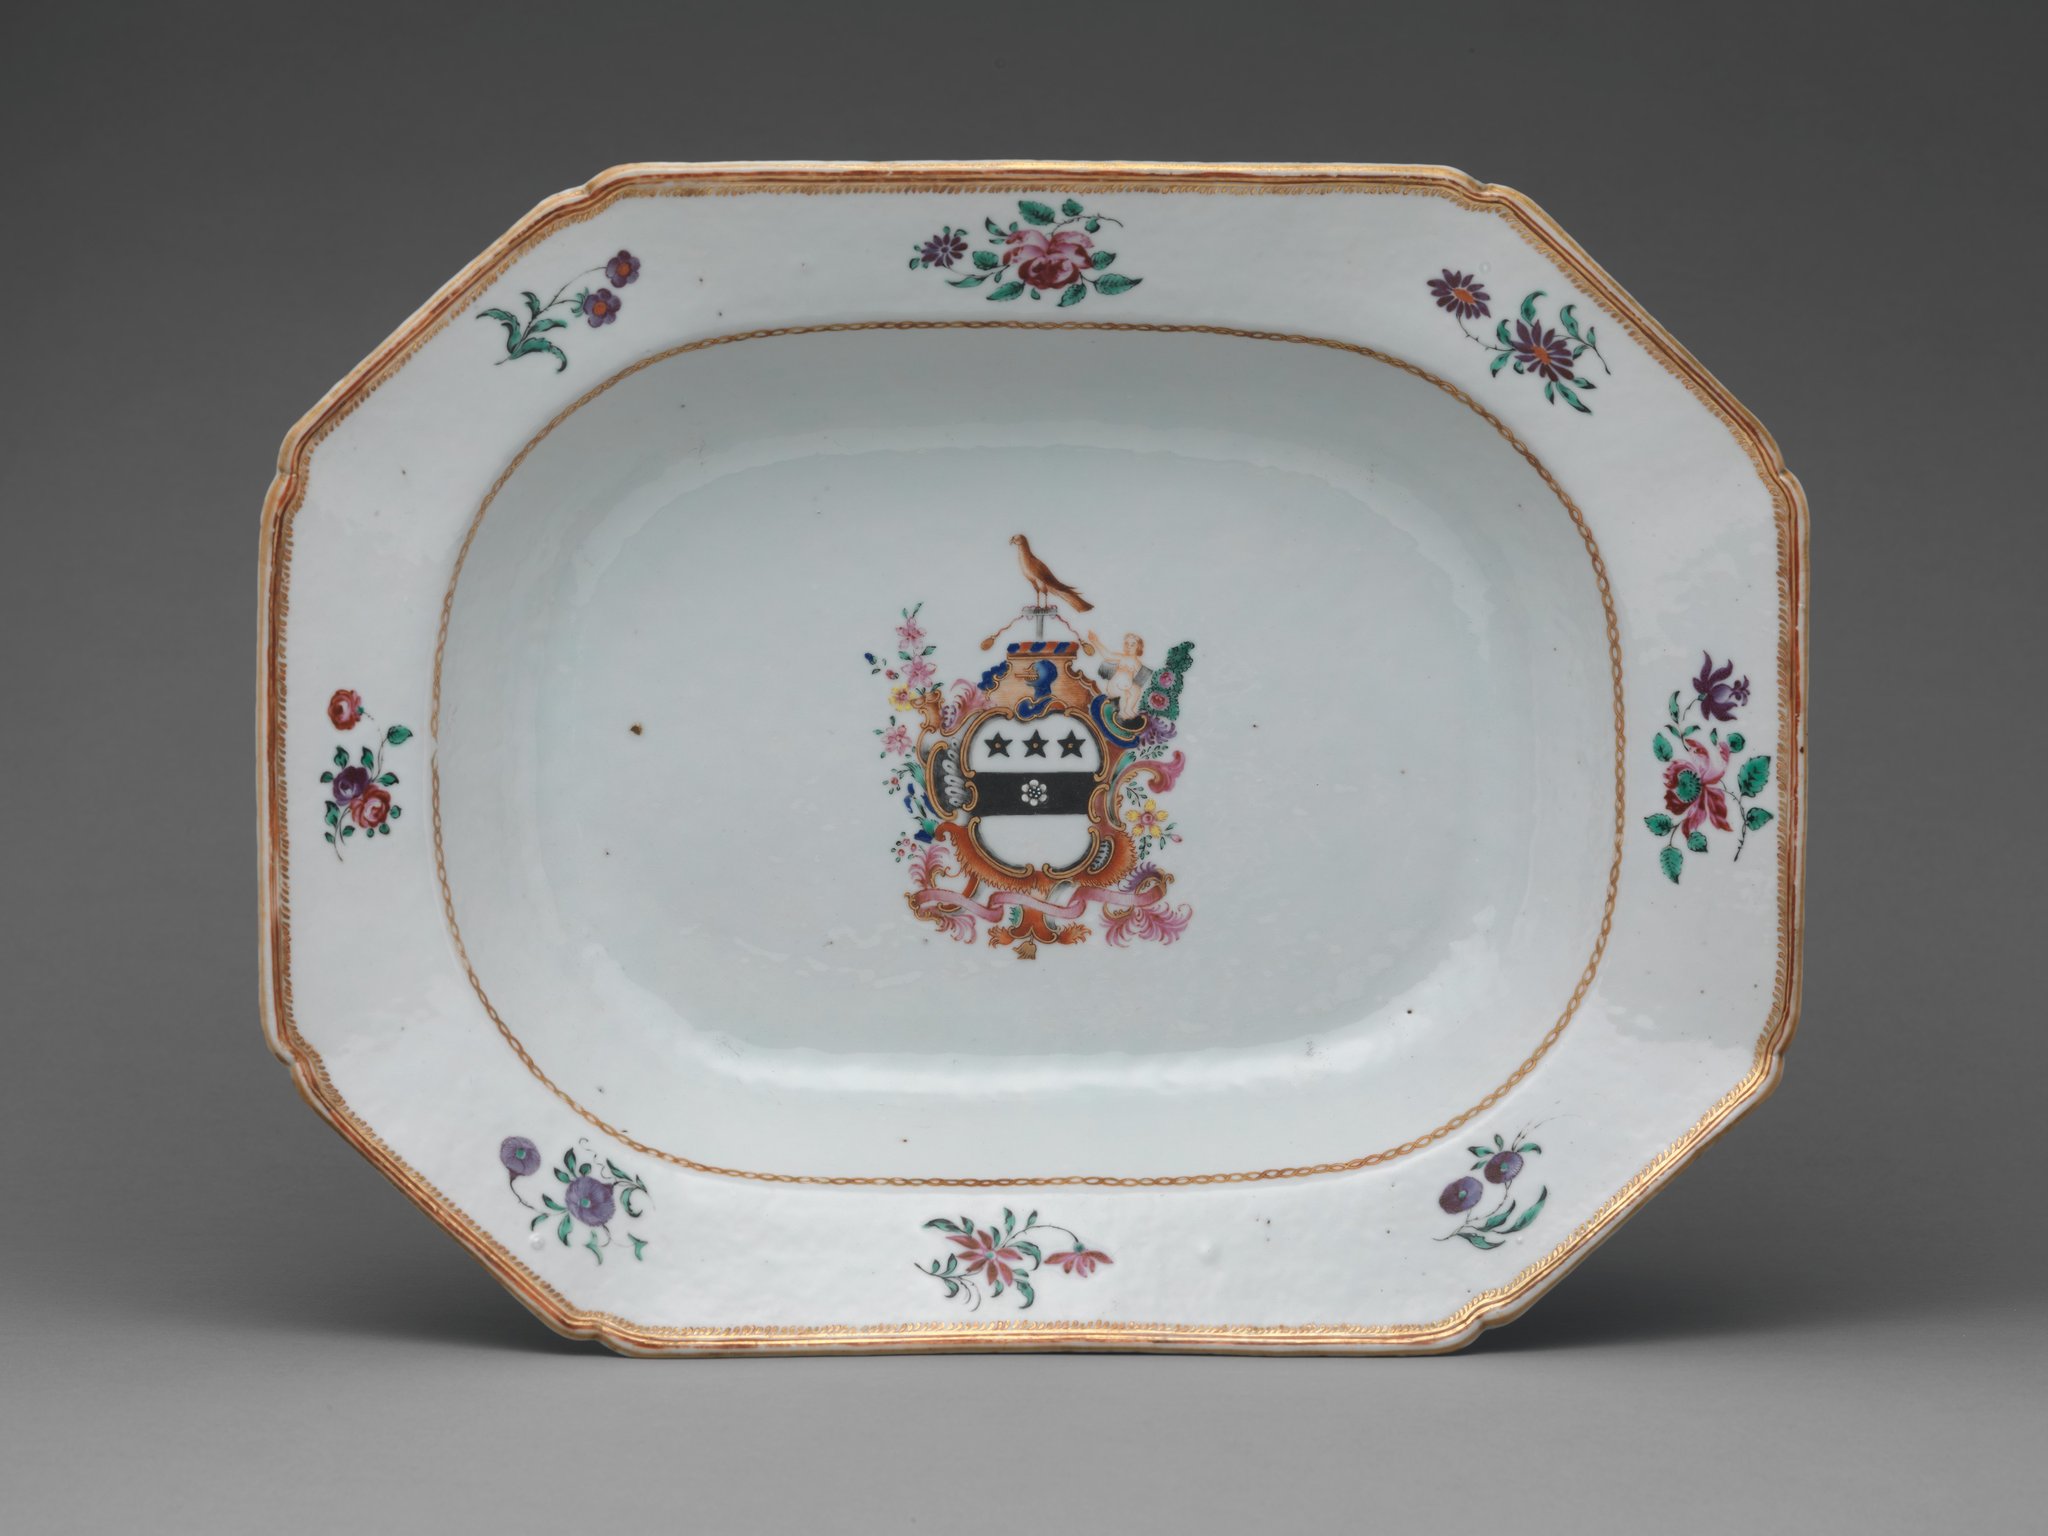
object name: platter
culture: chinese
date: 1785-1790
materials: porcelain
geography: china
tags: birds,coat of arms